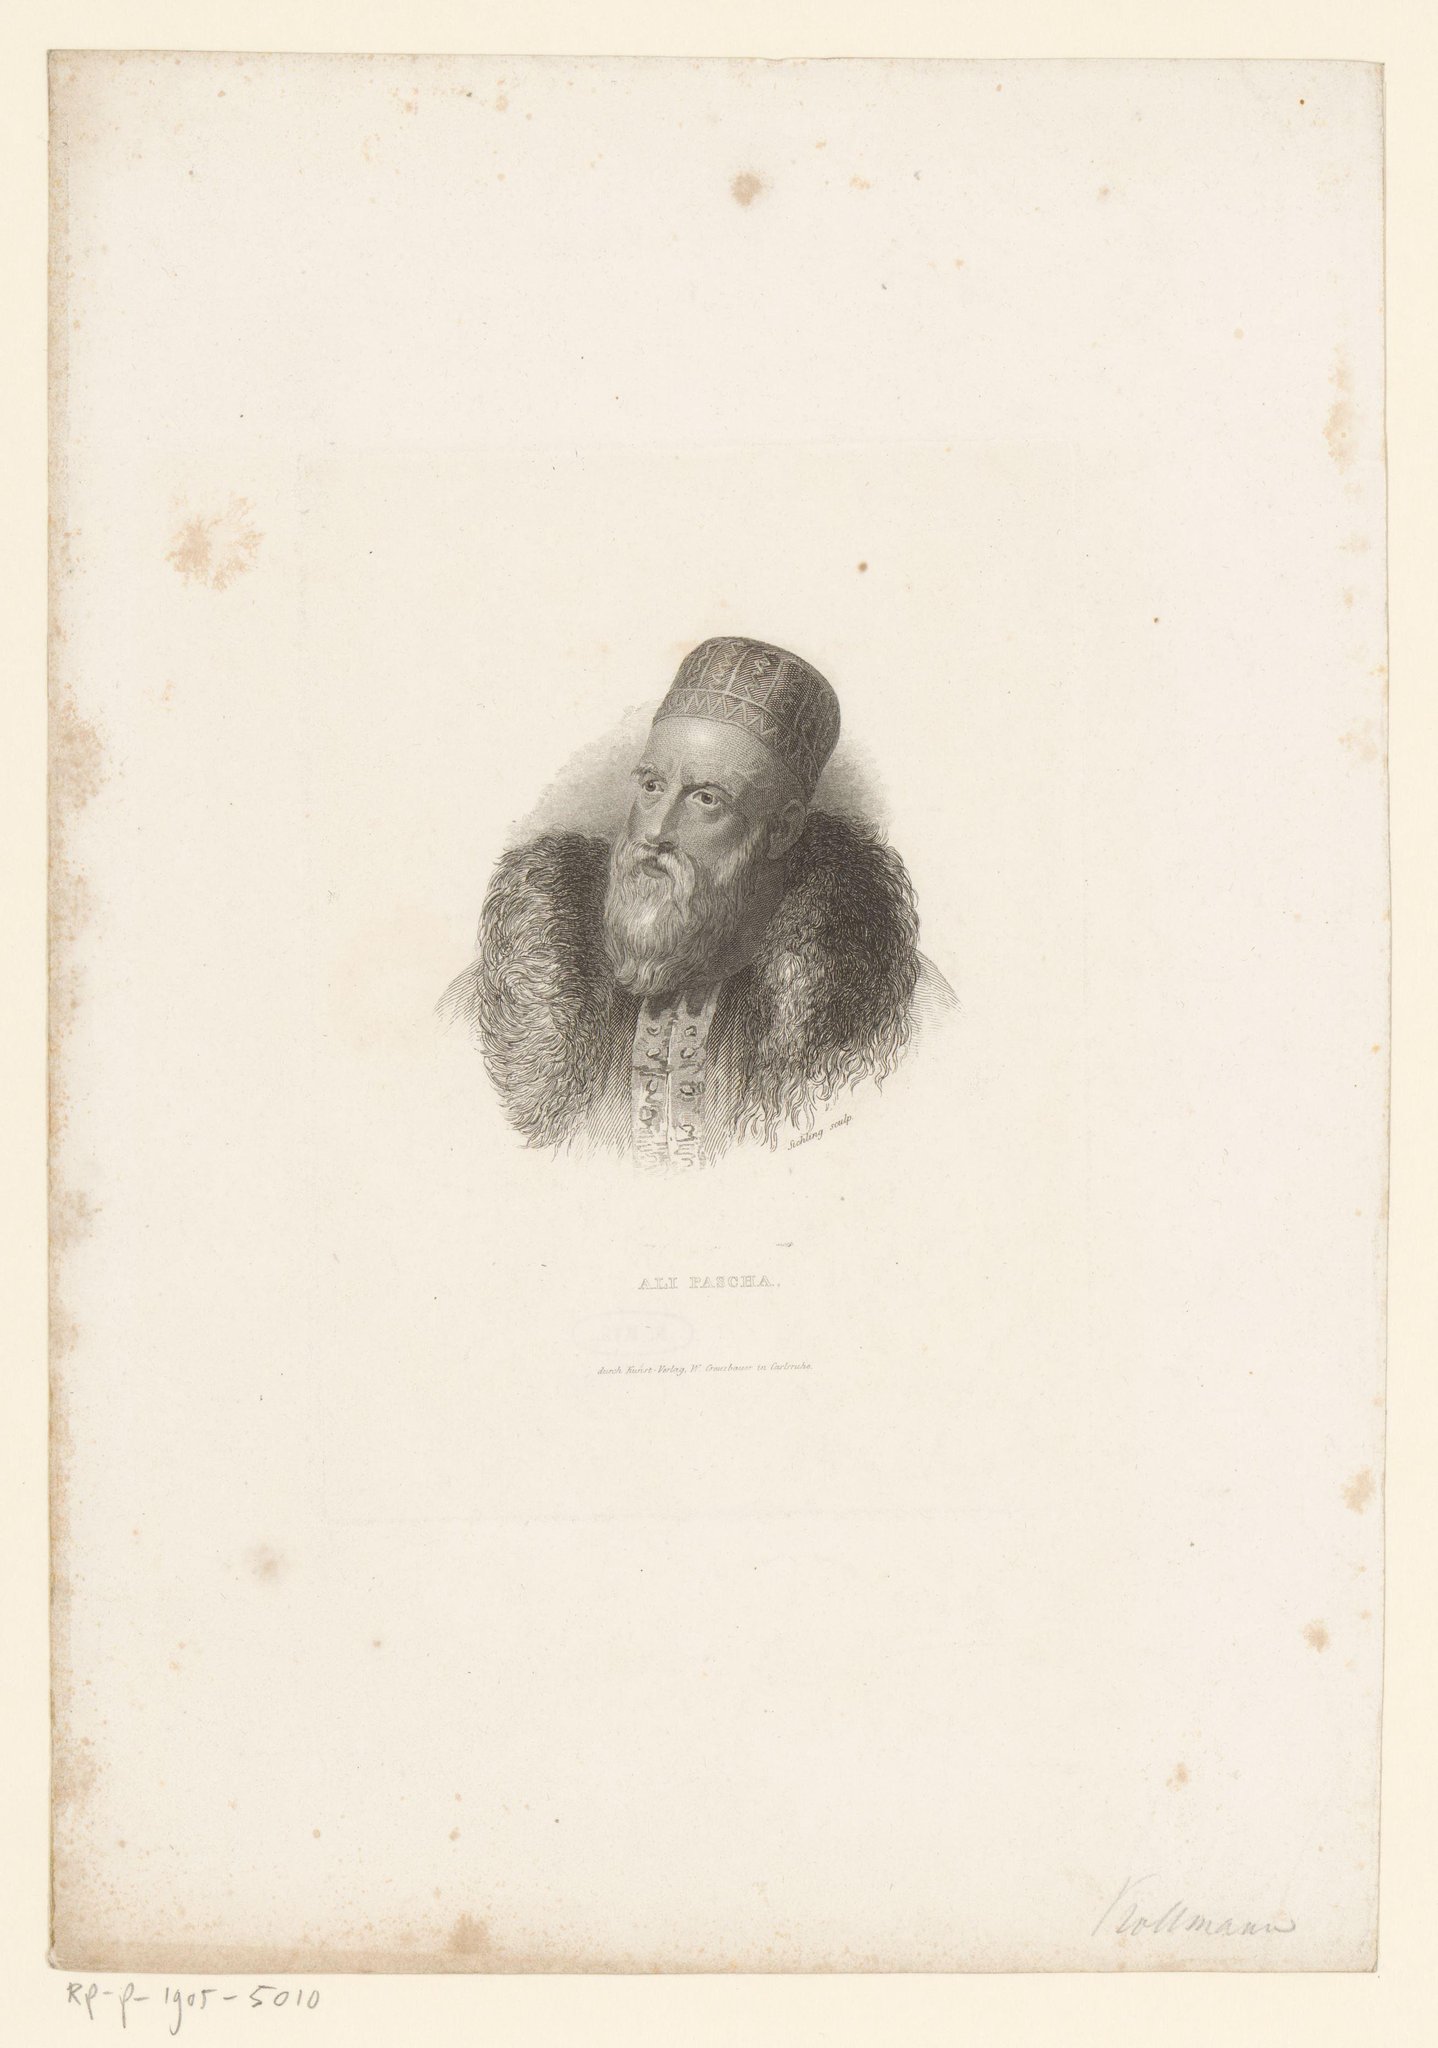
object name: print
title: Portret van Ali Pasja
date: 1822-1863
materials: paper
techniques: engraving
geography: karlsruhe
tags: historical persons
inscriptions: collector's mark: Lugt 2228